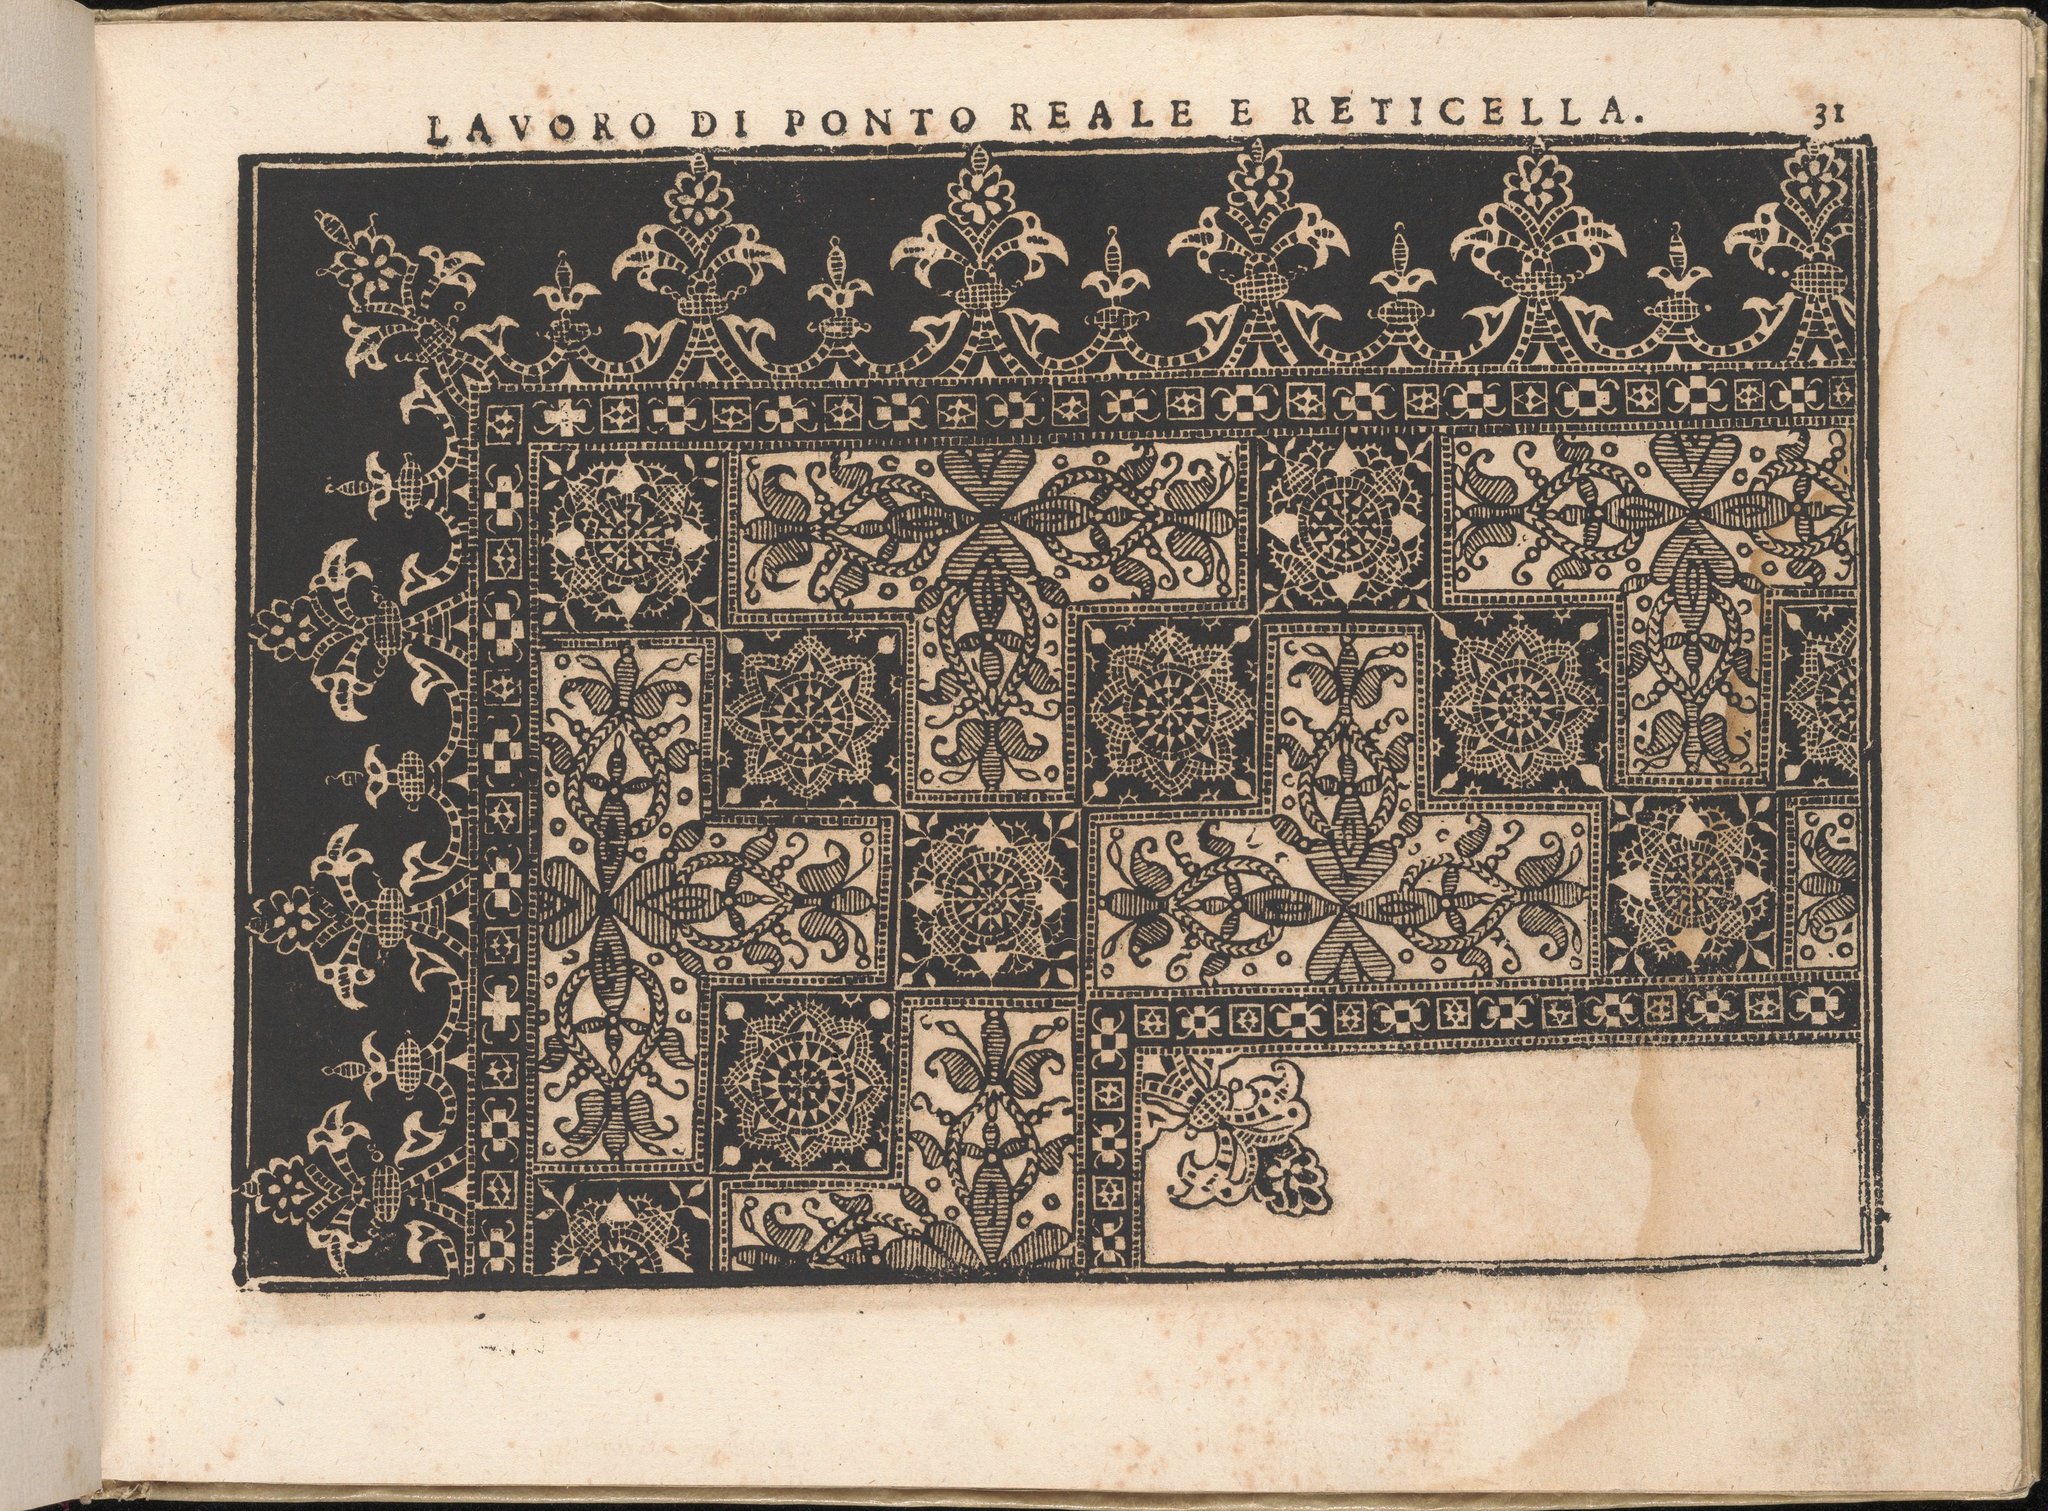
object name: book print ornament architecture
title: Fiore D'Ogni Virtu Per le Nobili Et Honeste Matrone, page 31 (recto)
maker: isabella catanea parasole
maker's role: designer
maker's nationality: italian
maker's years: 1565-1625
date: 1610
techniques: woodcut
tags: ornament,flowers